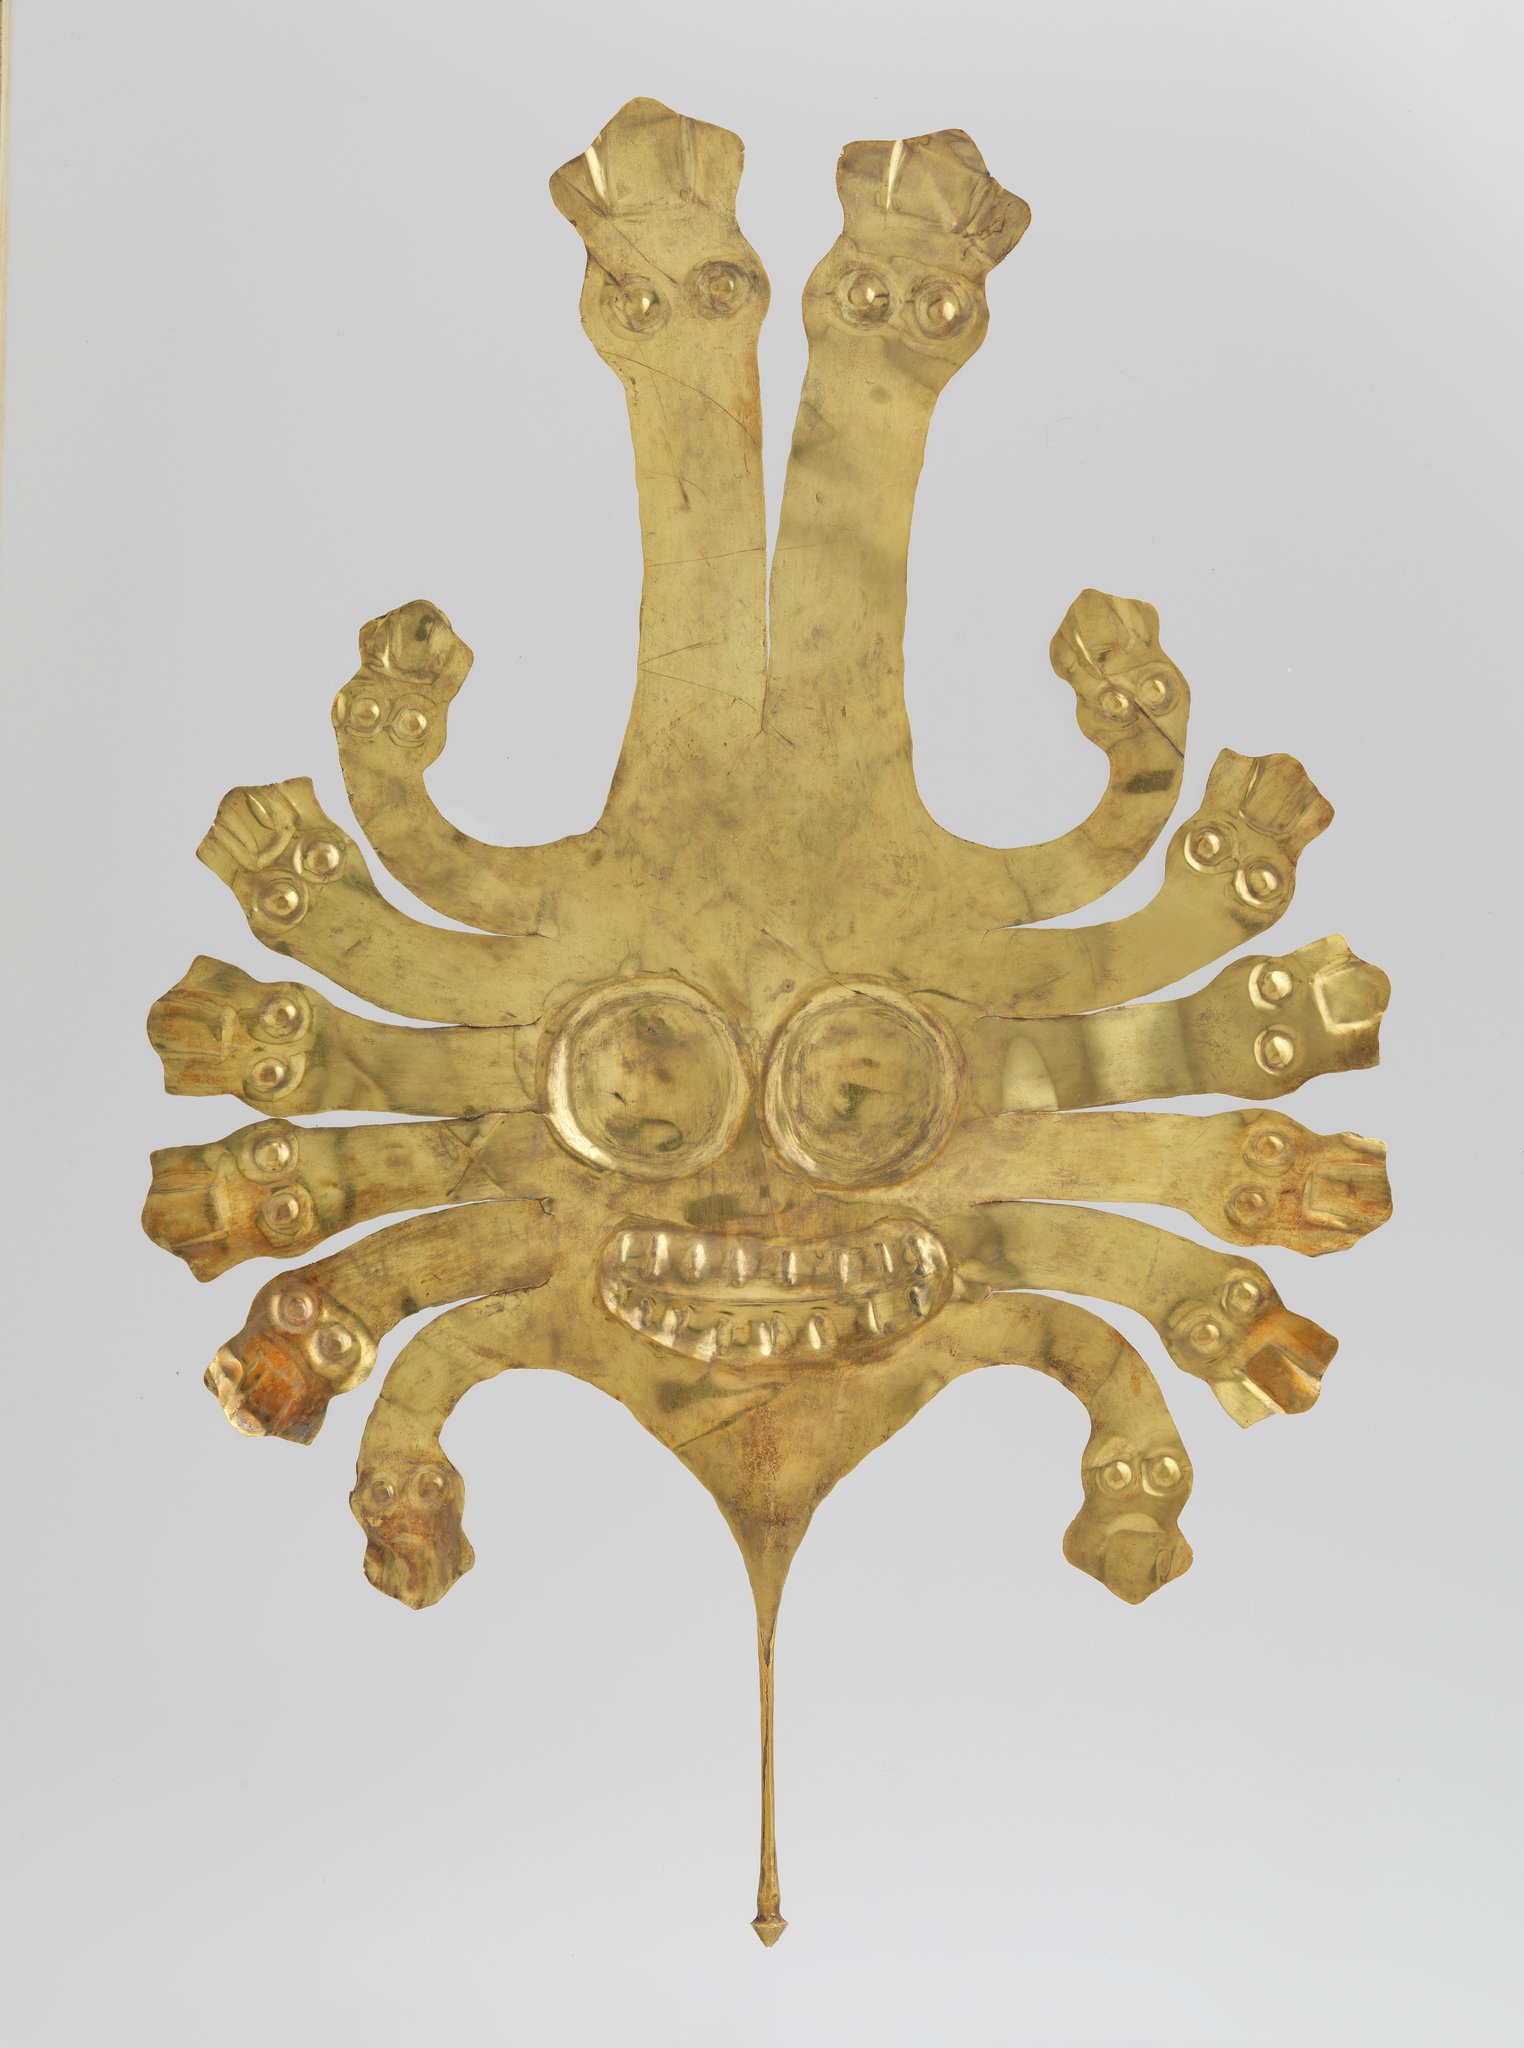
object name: ornament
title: Headdress ornament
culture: nasca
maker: nasca artist(s)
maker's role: artist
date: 1-700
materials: gold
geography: peru